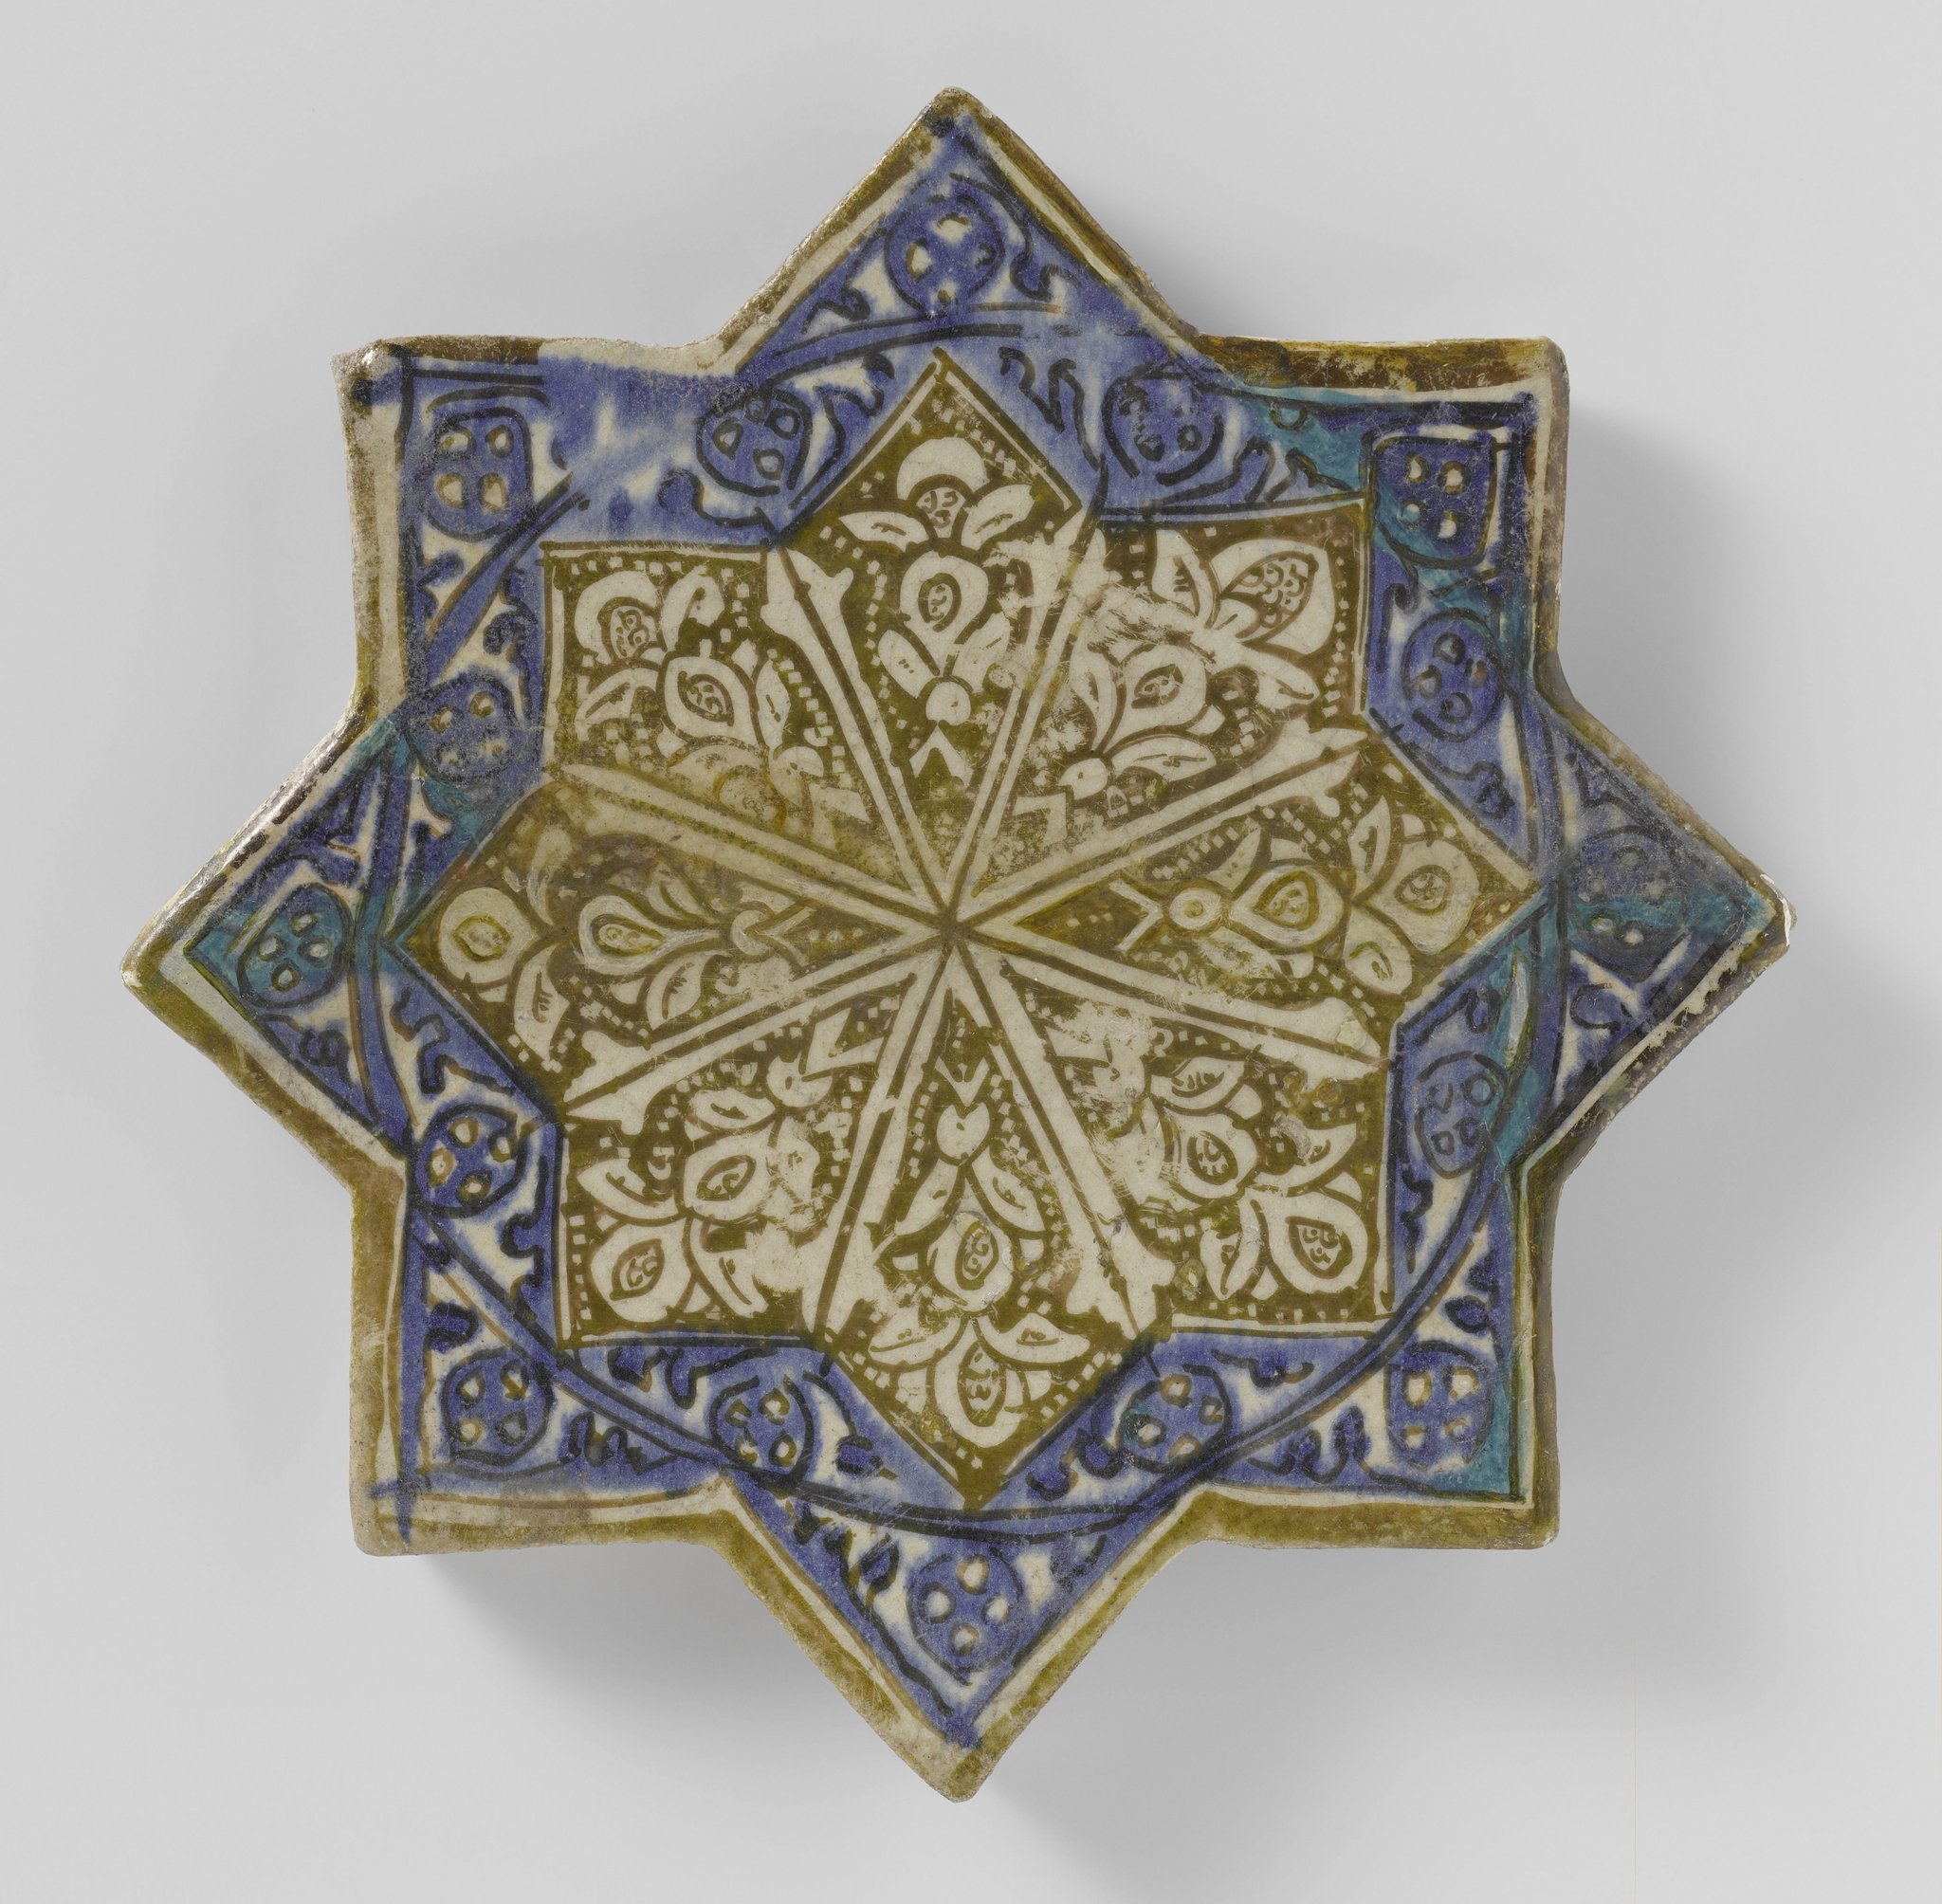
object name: stertegel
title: Star-shaped tile with floral scrolls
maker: Anonymous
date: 1250-1324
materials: cobalt, earthenware, glaze, luster, paint, quartz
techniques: firing, forming, vitrification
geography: kashan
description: Stervormige tegel van kwarts-fritgoed, beschilderd in onderglazuur blauw, blauw-groen en luster met een rand van palmetten en twee lijnen waarbinnen een ster met uitgespaarde bloem- en bladranken.